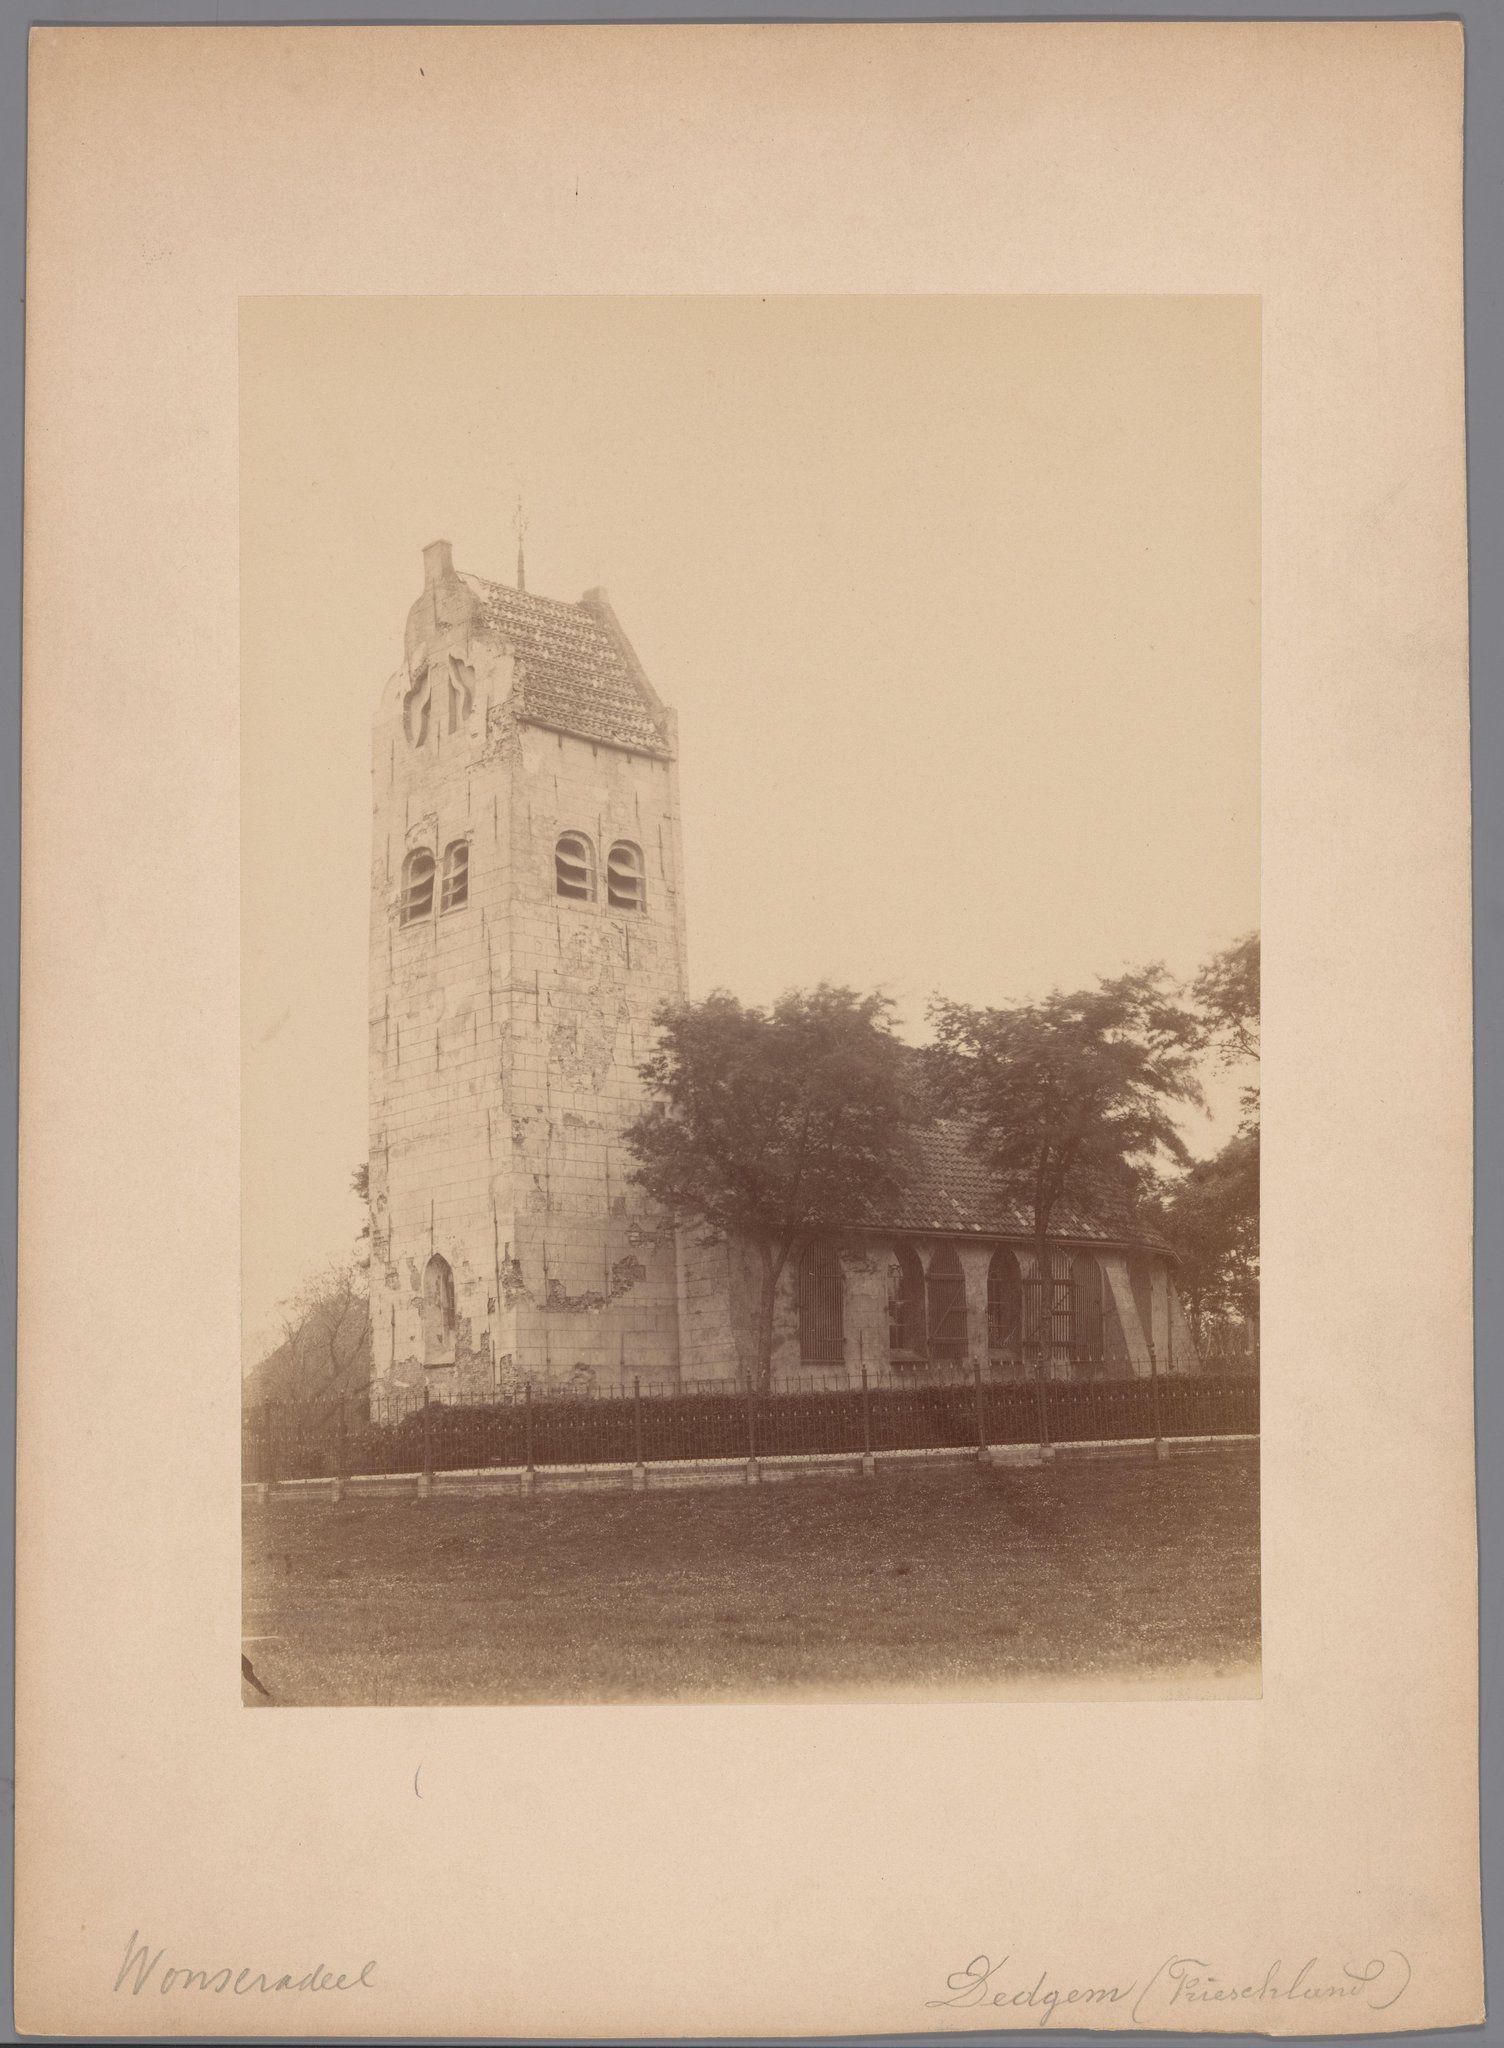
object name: photograph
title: Gezicht op de voormalige Hervormde Kerk te Dedgum, gesloopt in 1889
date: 1880-1889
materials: cardboard, photographic support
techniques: albumen print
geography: dedgum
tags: church (exterior)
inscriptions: annotation: ‘Wonseradeel/ Dedgem (Friesland)’, annotation: ‘Dedgem (fr. / N.H. Kerk’